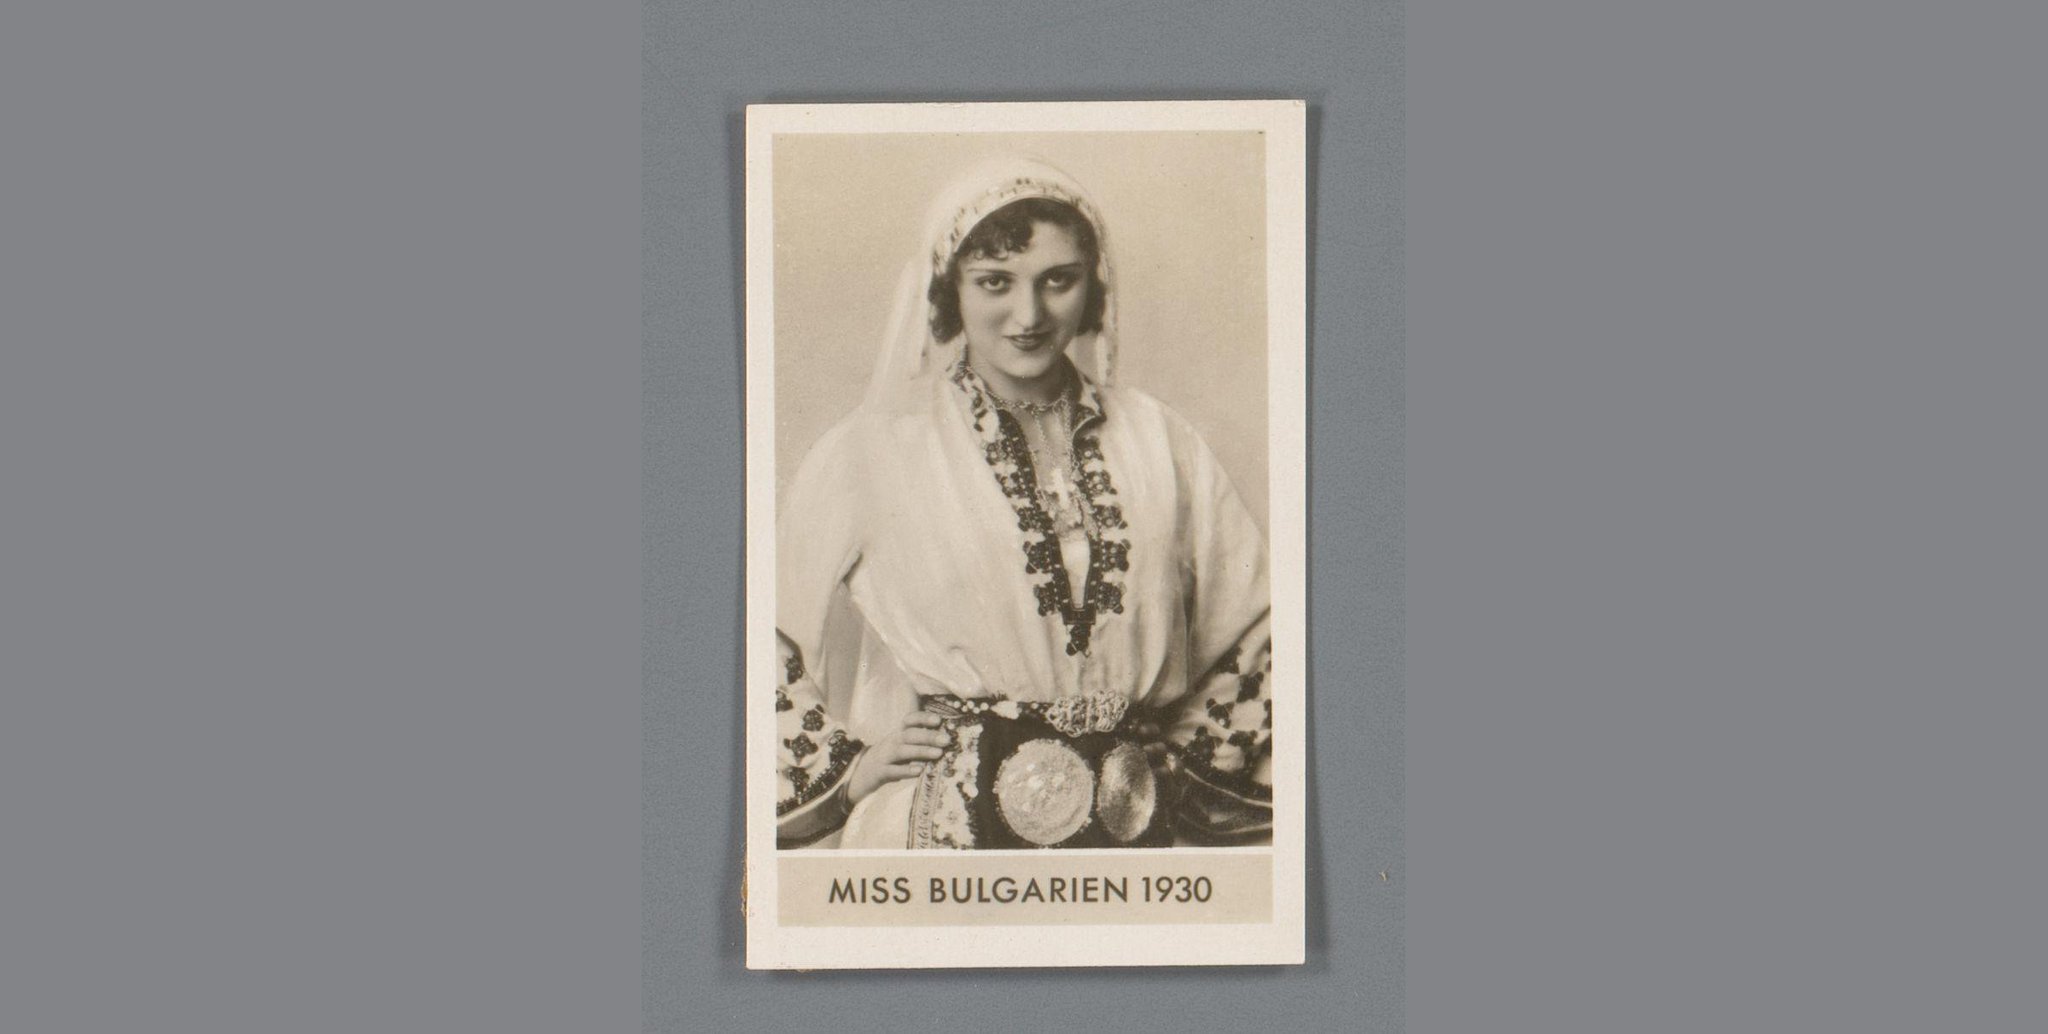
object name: photograph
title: Miss Bulgarien 1930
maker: Anonymous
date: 1930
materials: paper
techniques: gelatin silver print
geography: dresden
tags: historical persons - bb - woman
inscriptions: inscription: ‘Die schönsten/ Frauen der Welt/ dargestellt durch die Schön-/ heitsköniginnen aller Länder,/ finden Sie in 190 echten/ Bromsilber-Fotos, die nur den/ CLUB-und-LIGA-Packun-/ gen beiliegen. Eind prächtiges/ Sammel-Album erhalten Sie/ für 75 Pfennig vom Händler/ oder bei Einsendung von/ 75 Pfennig in Briefmarken/ von der Bilderstelle Lohse,/ Dresden A24, Nossener Str. 1./ Ges. gesch. Nachdruck verboten!’